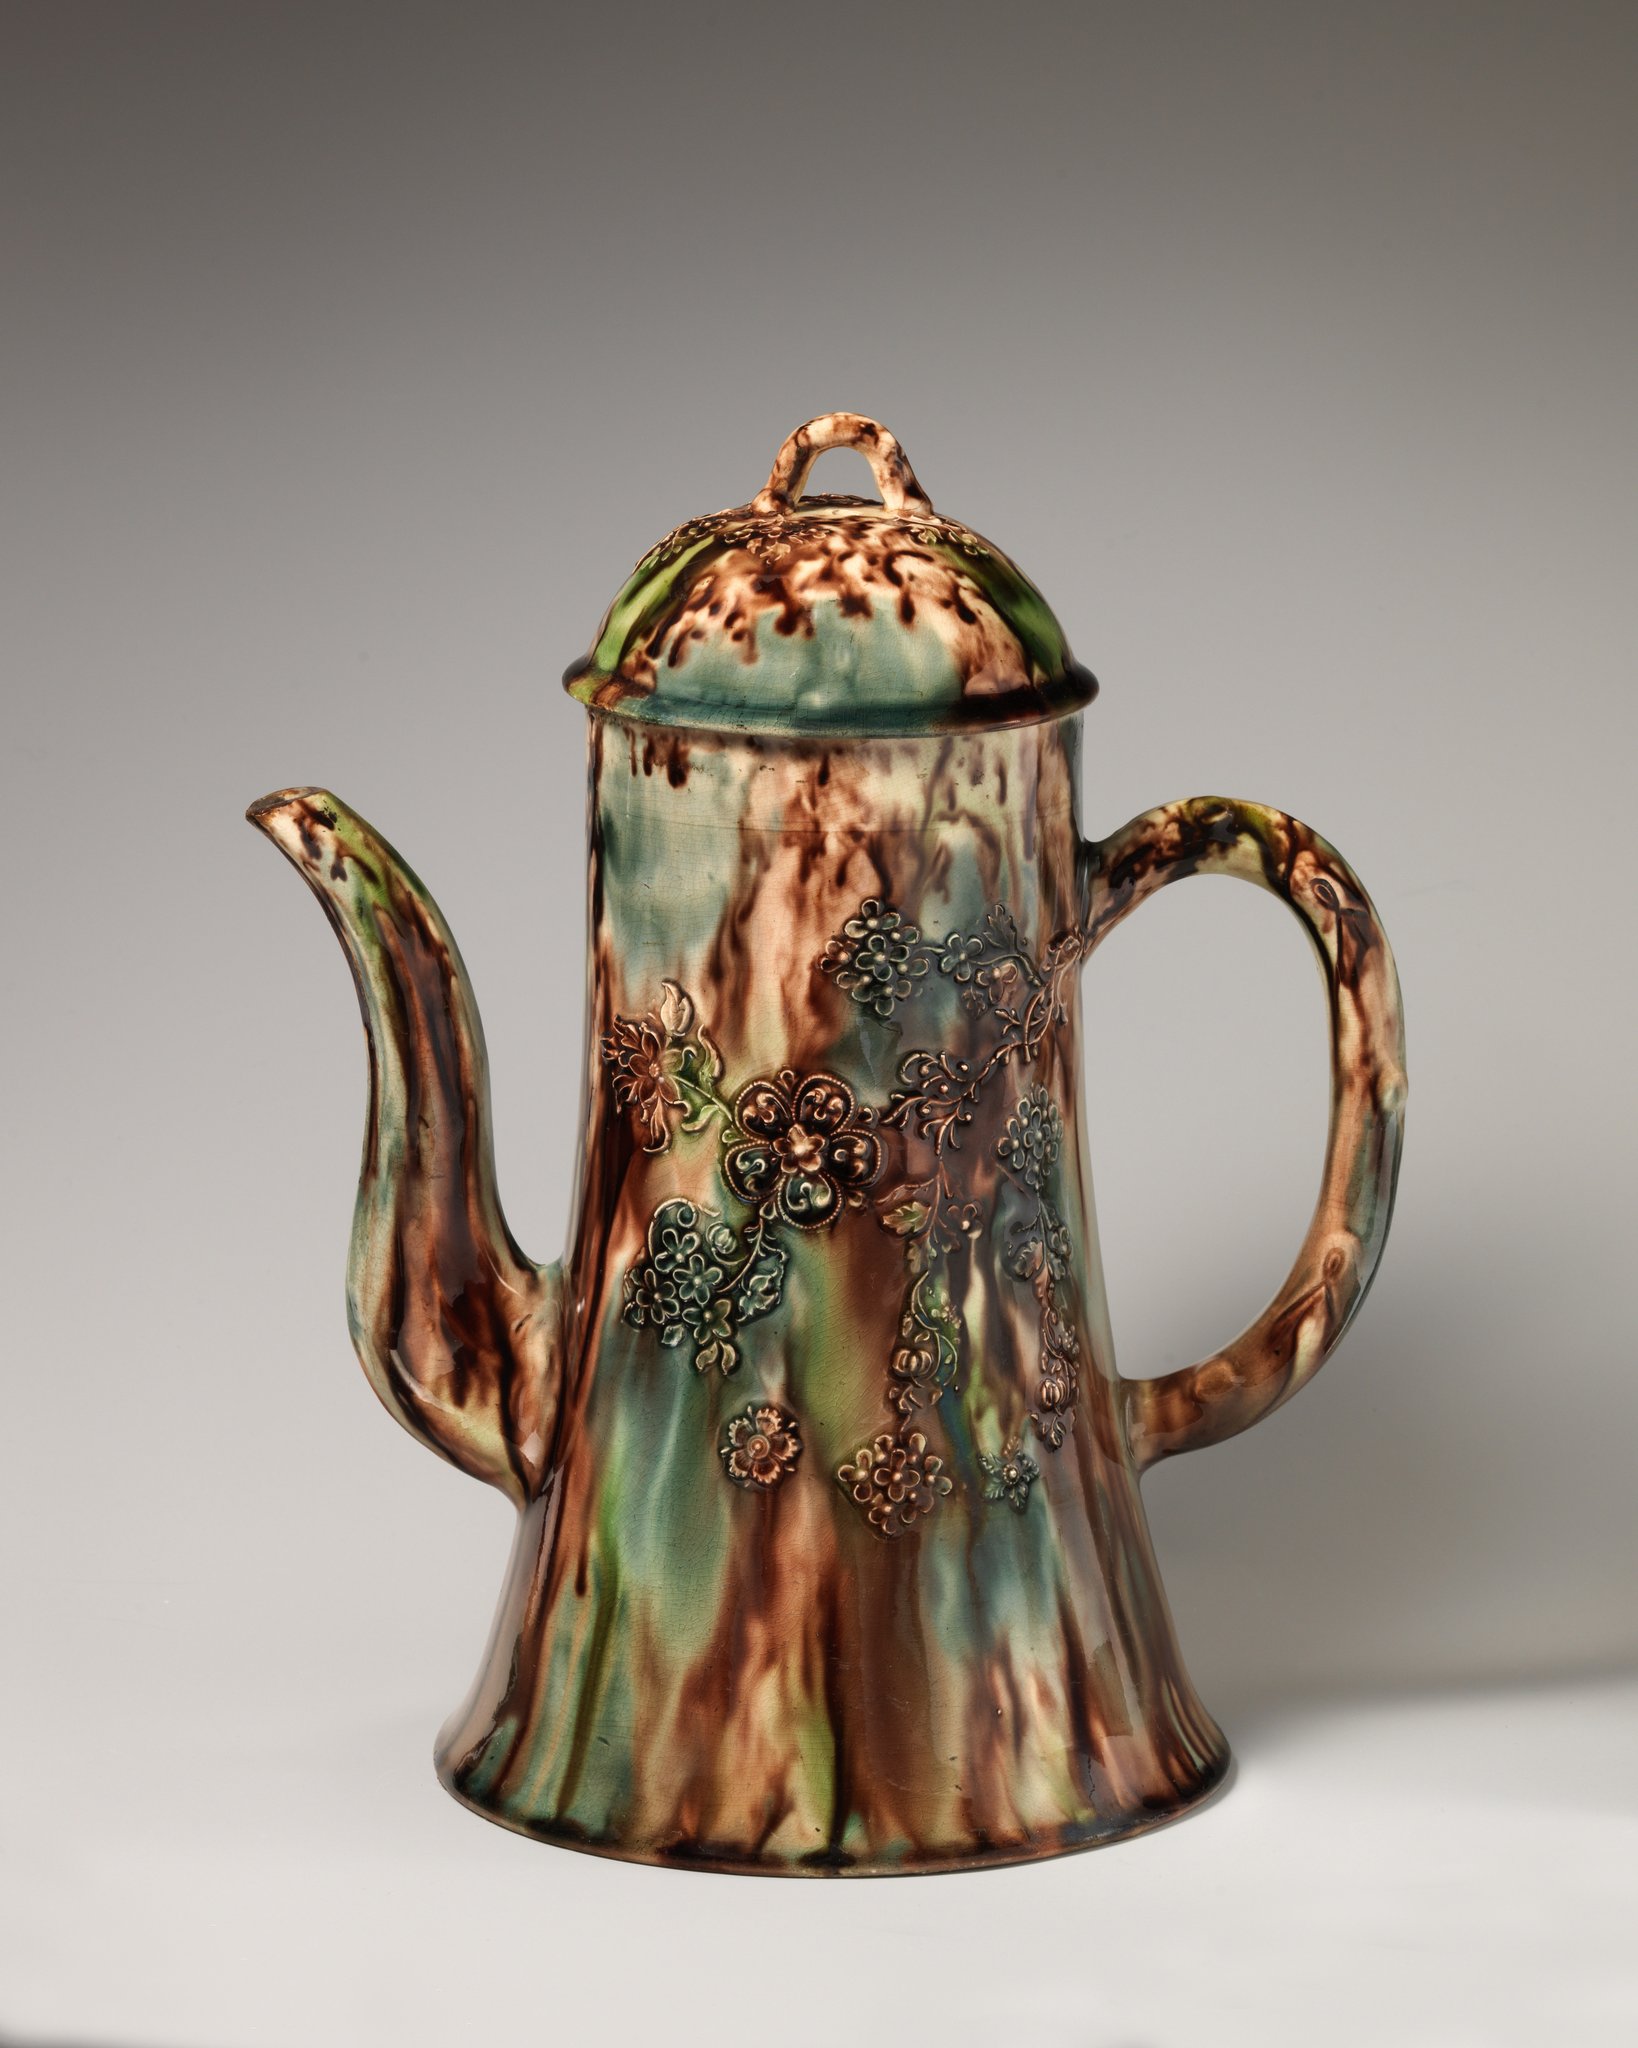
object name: coffeepot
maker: whieldon type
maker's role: maker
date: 1755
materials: earthenware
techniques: glazing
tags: flowers